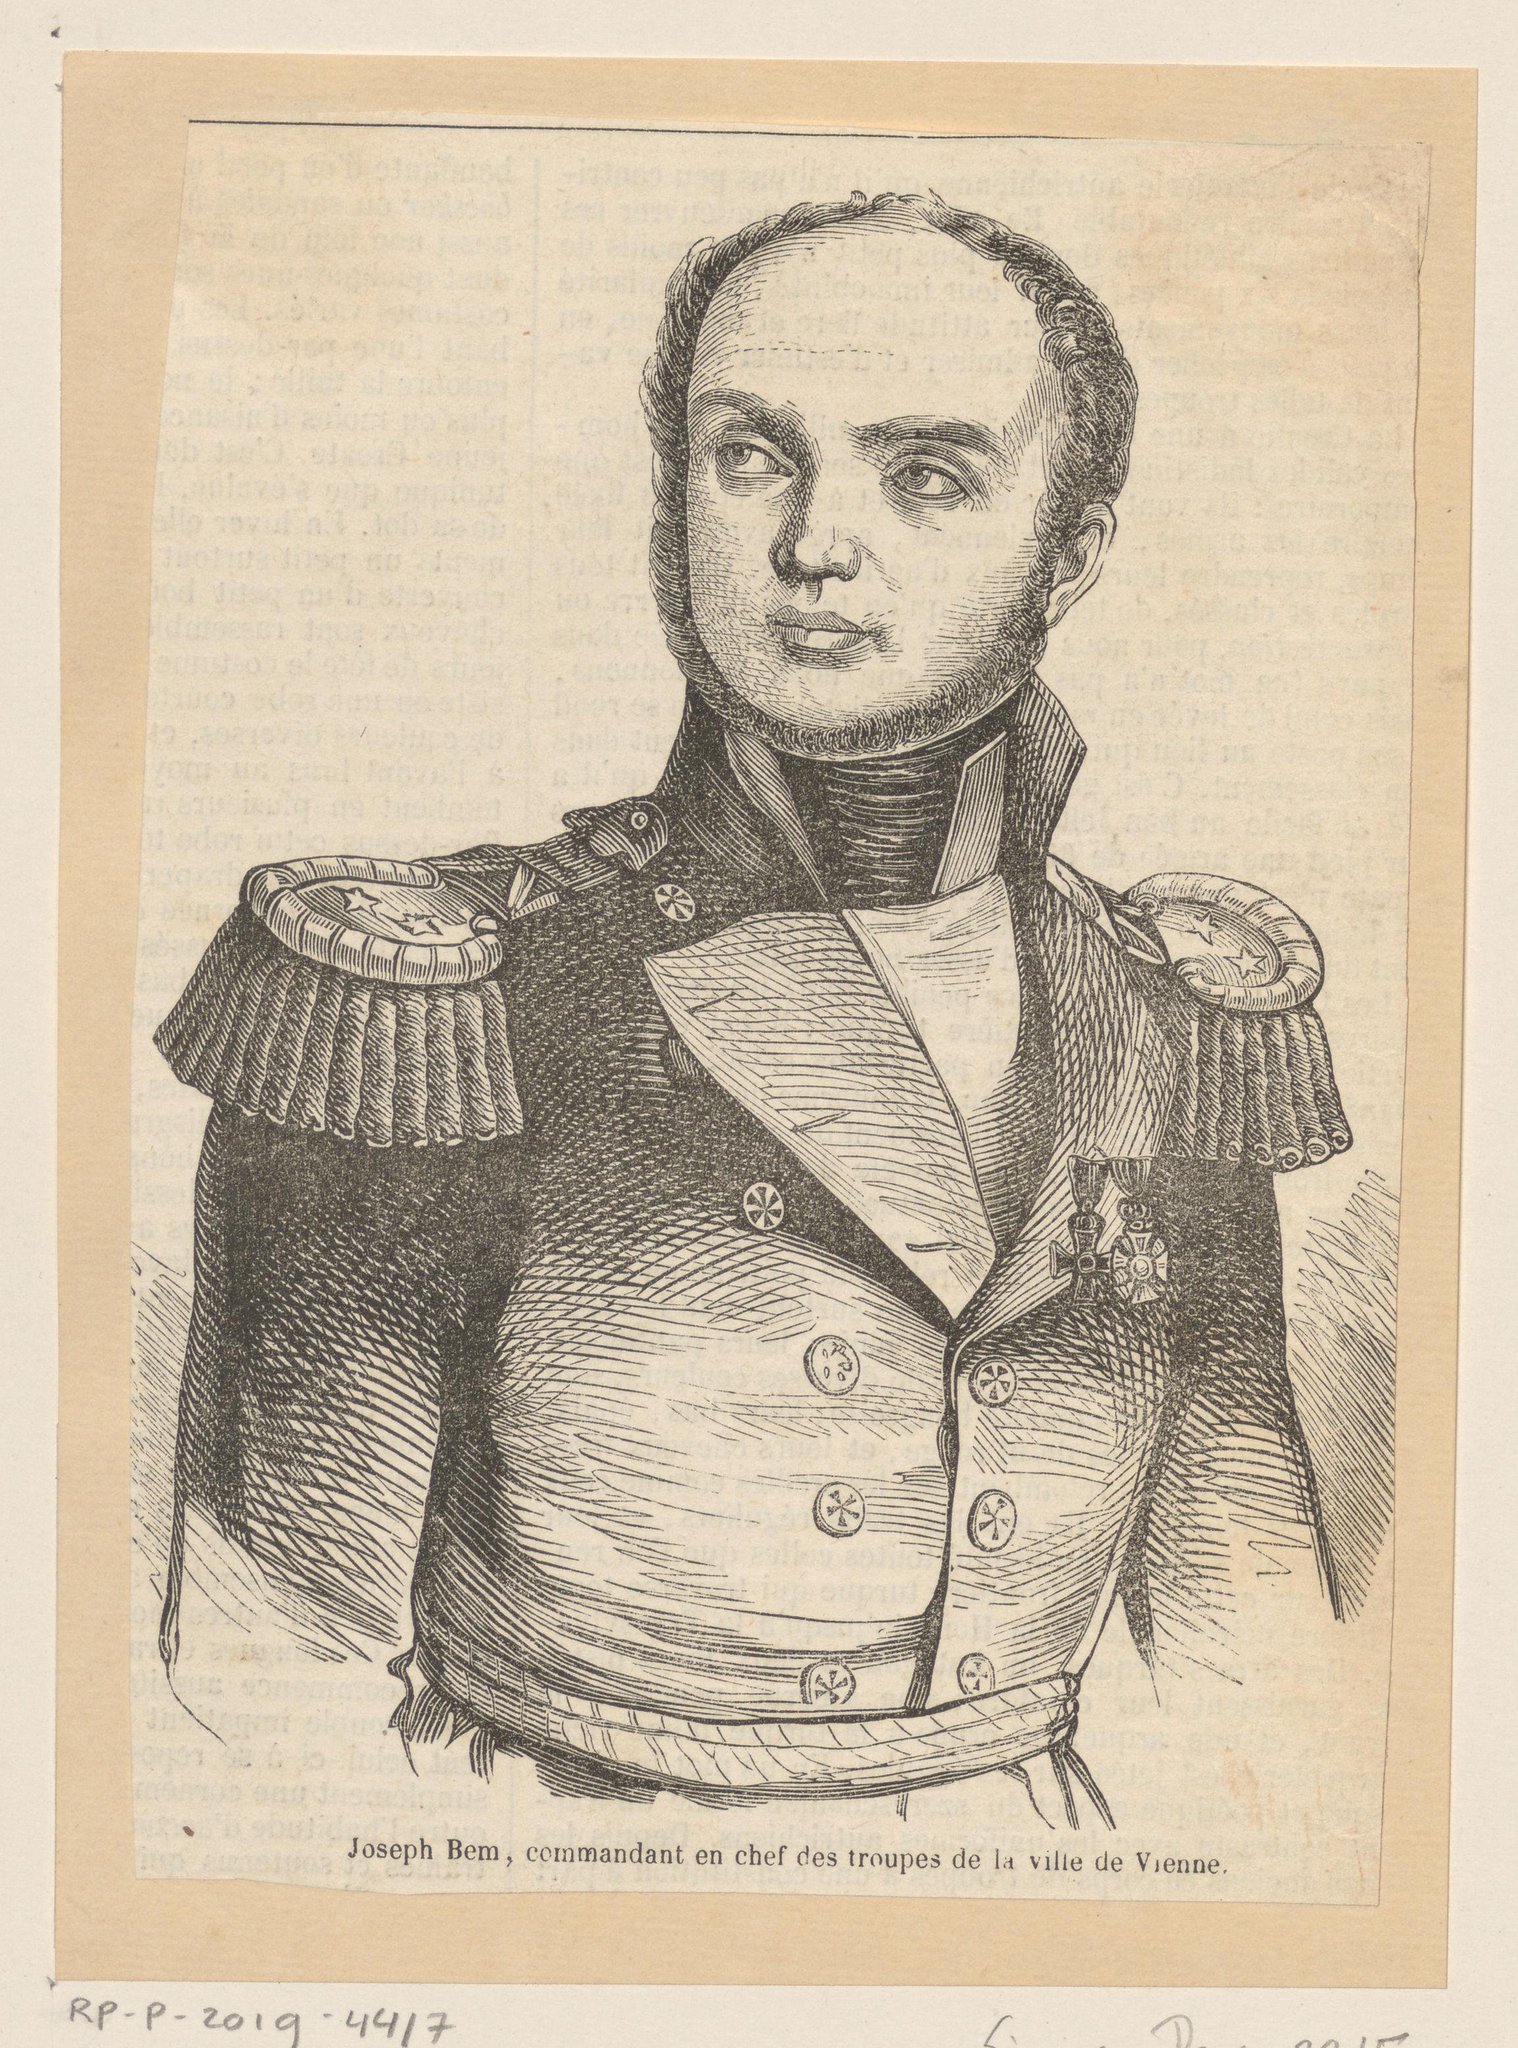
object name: photomechanical print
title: Portret van Józef Bem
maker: Anonymous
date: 1848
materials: paper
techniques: letterpress printing, printing block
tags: engineer, historical persons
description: Prent uit: L'Illustration, journal universel, nr. 298, 11 november 1848.